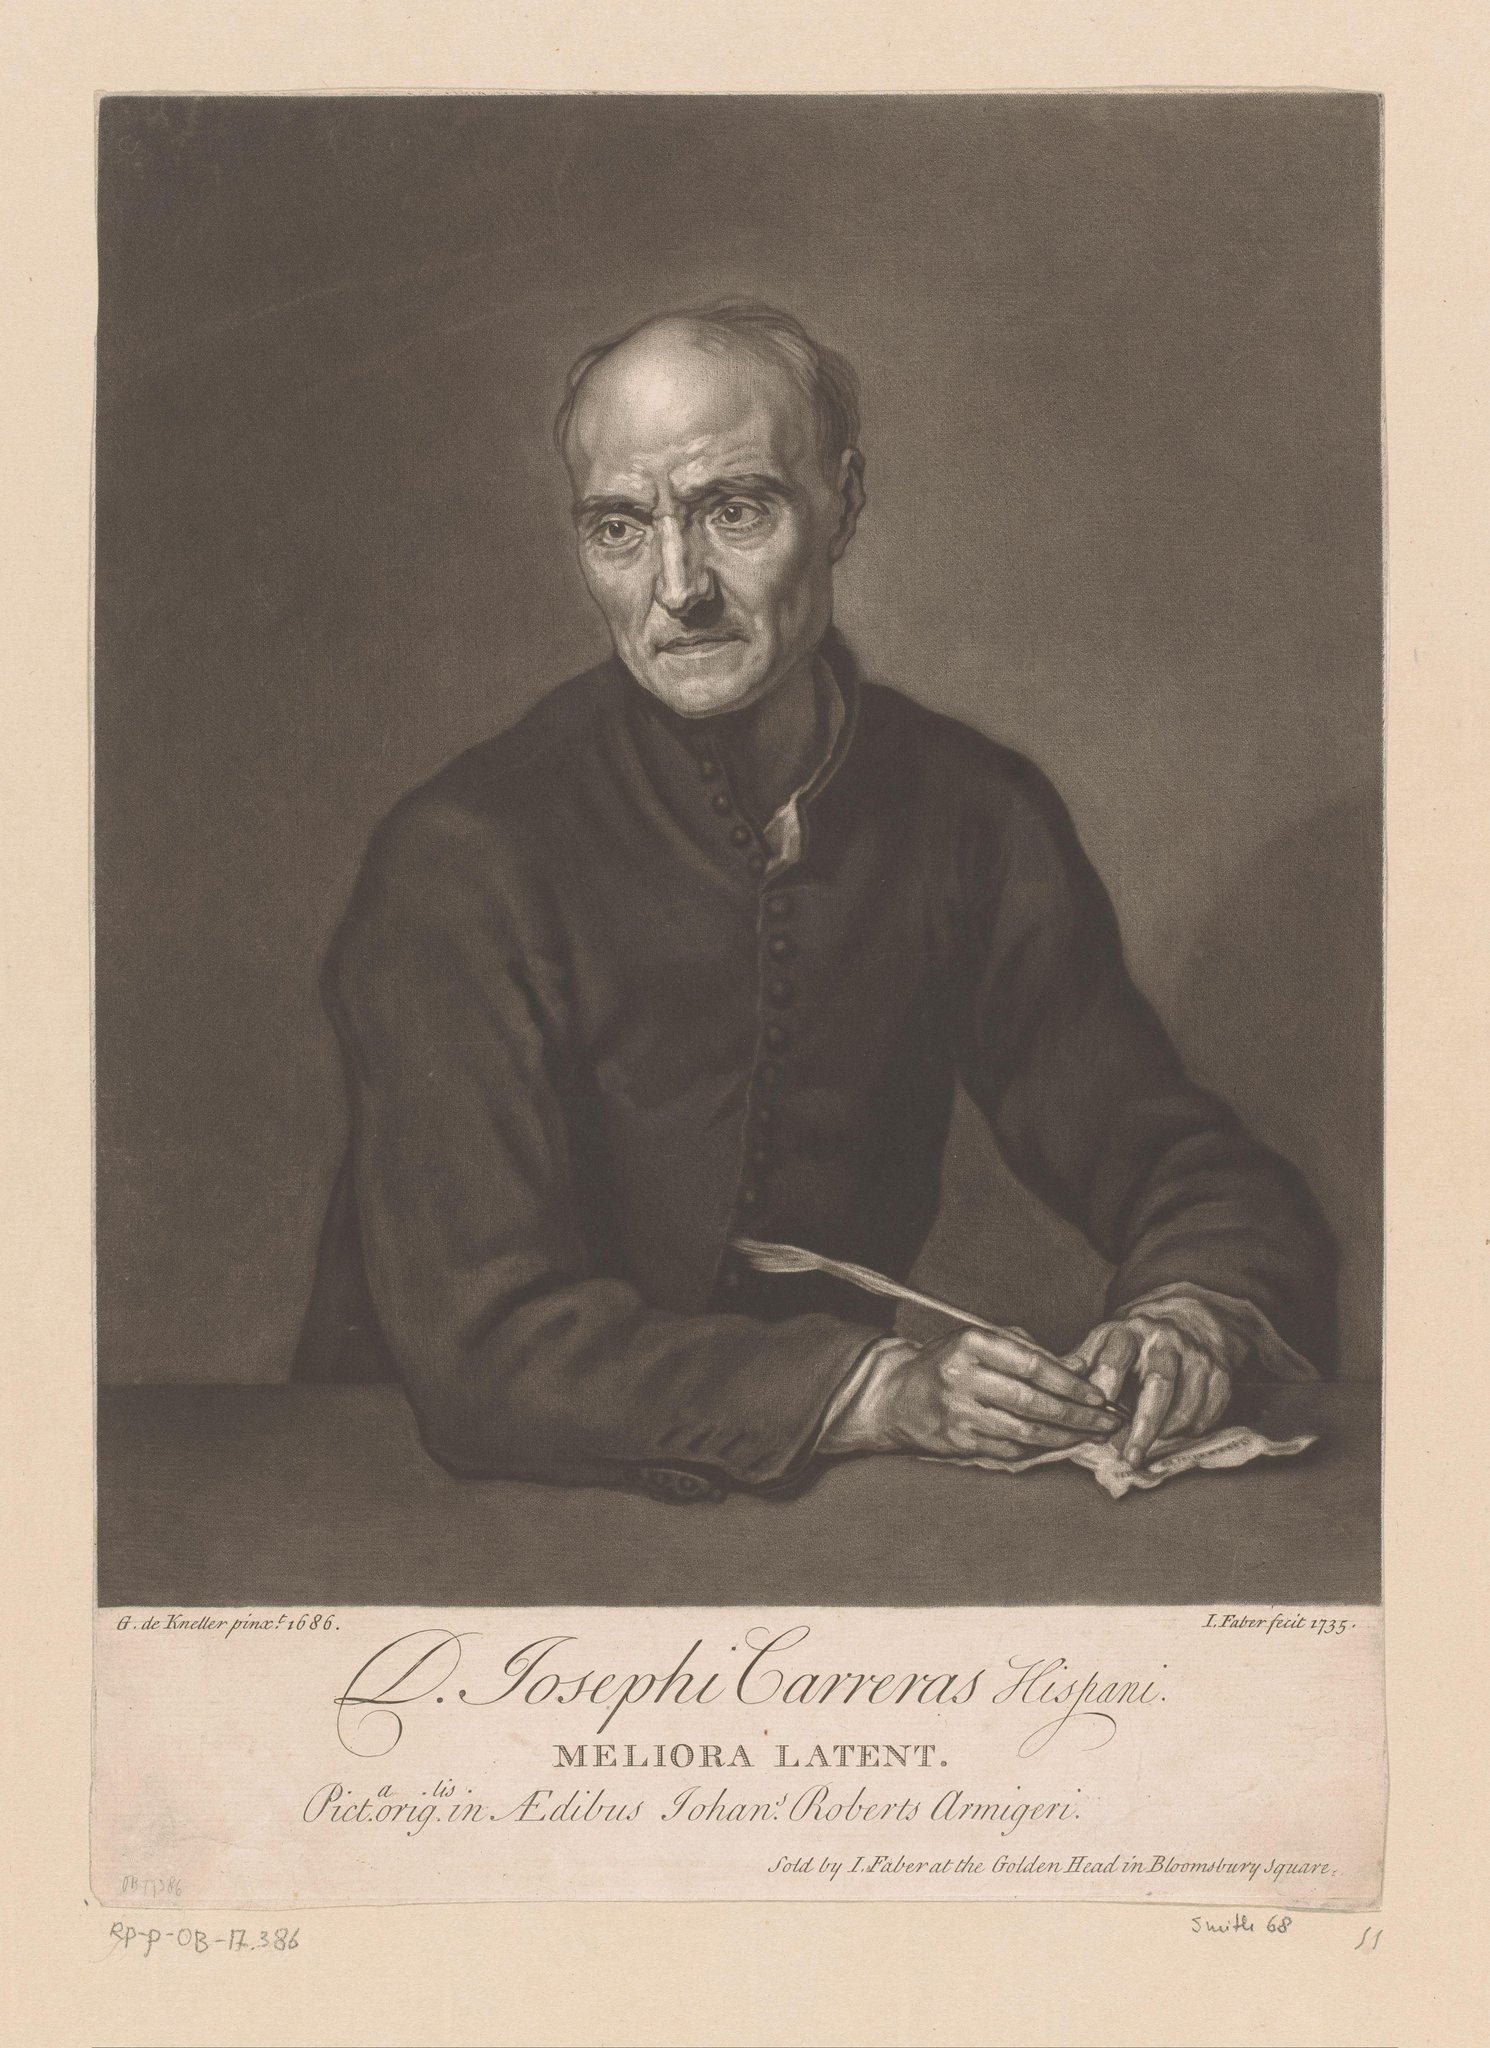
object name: print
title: D. Josephi Carreras Hispani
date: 1686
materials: paper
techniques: mezzotint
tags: historical persons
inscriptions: collector's mark: Lugt 240